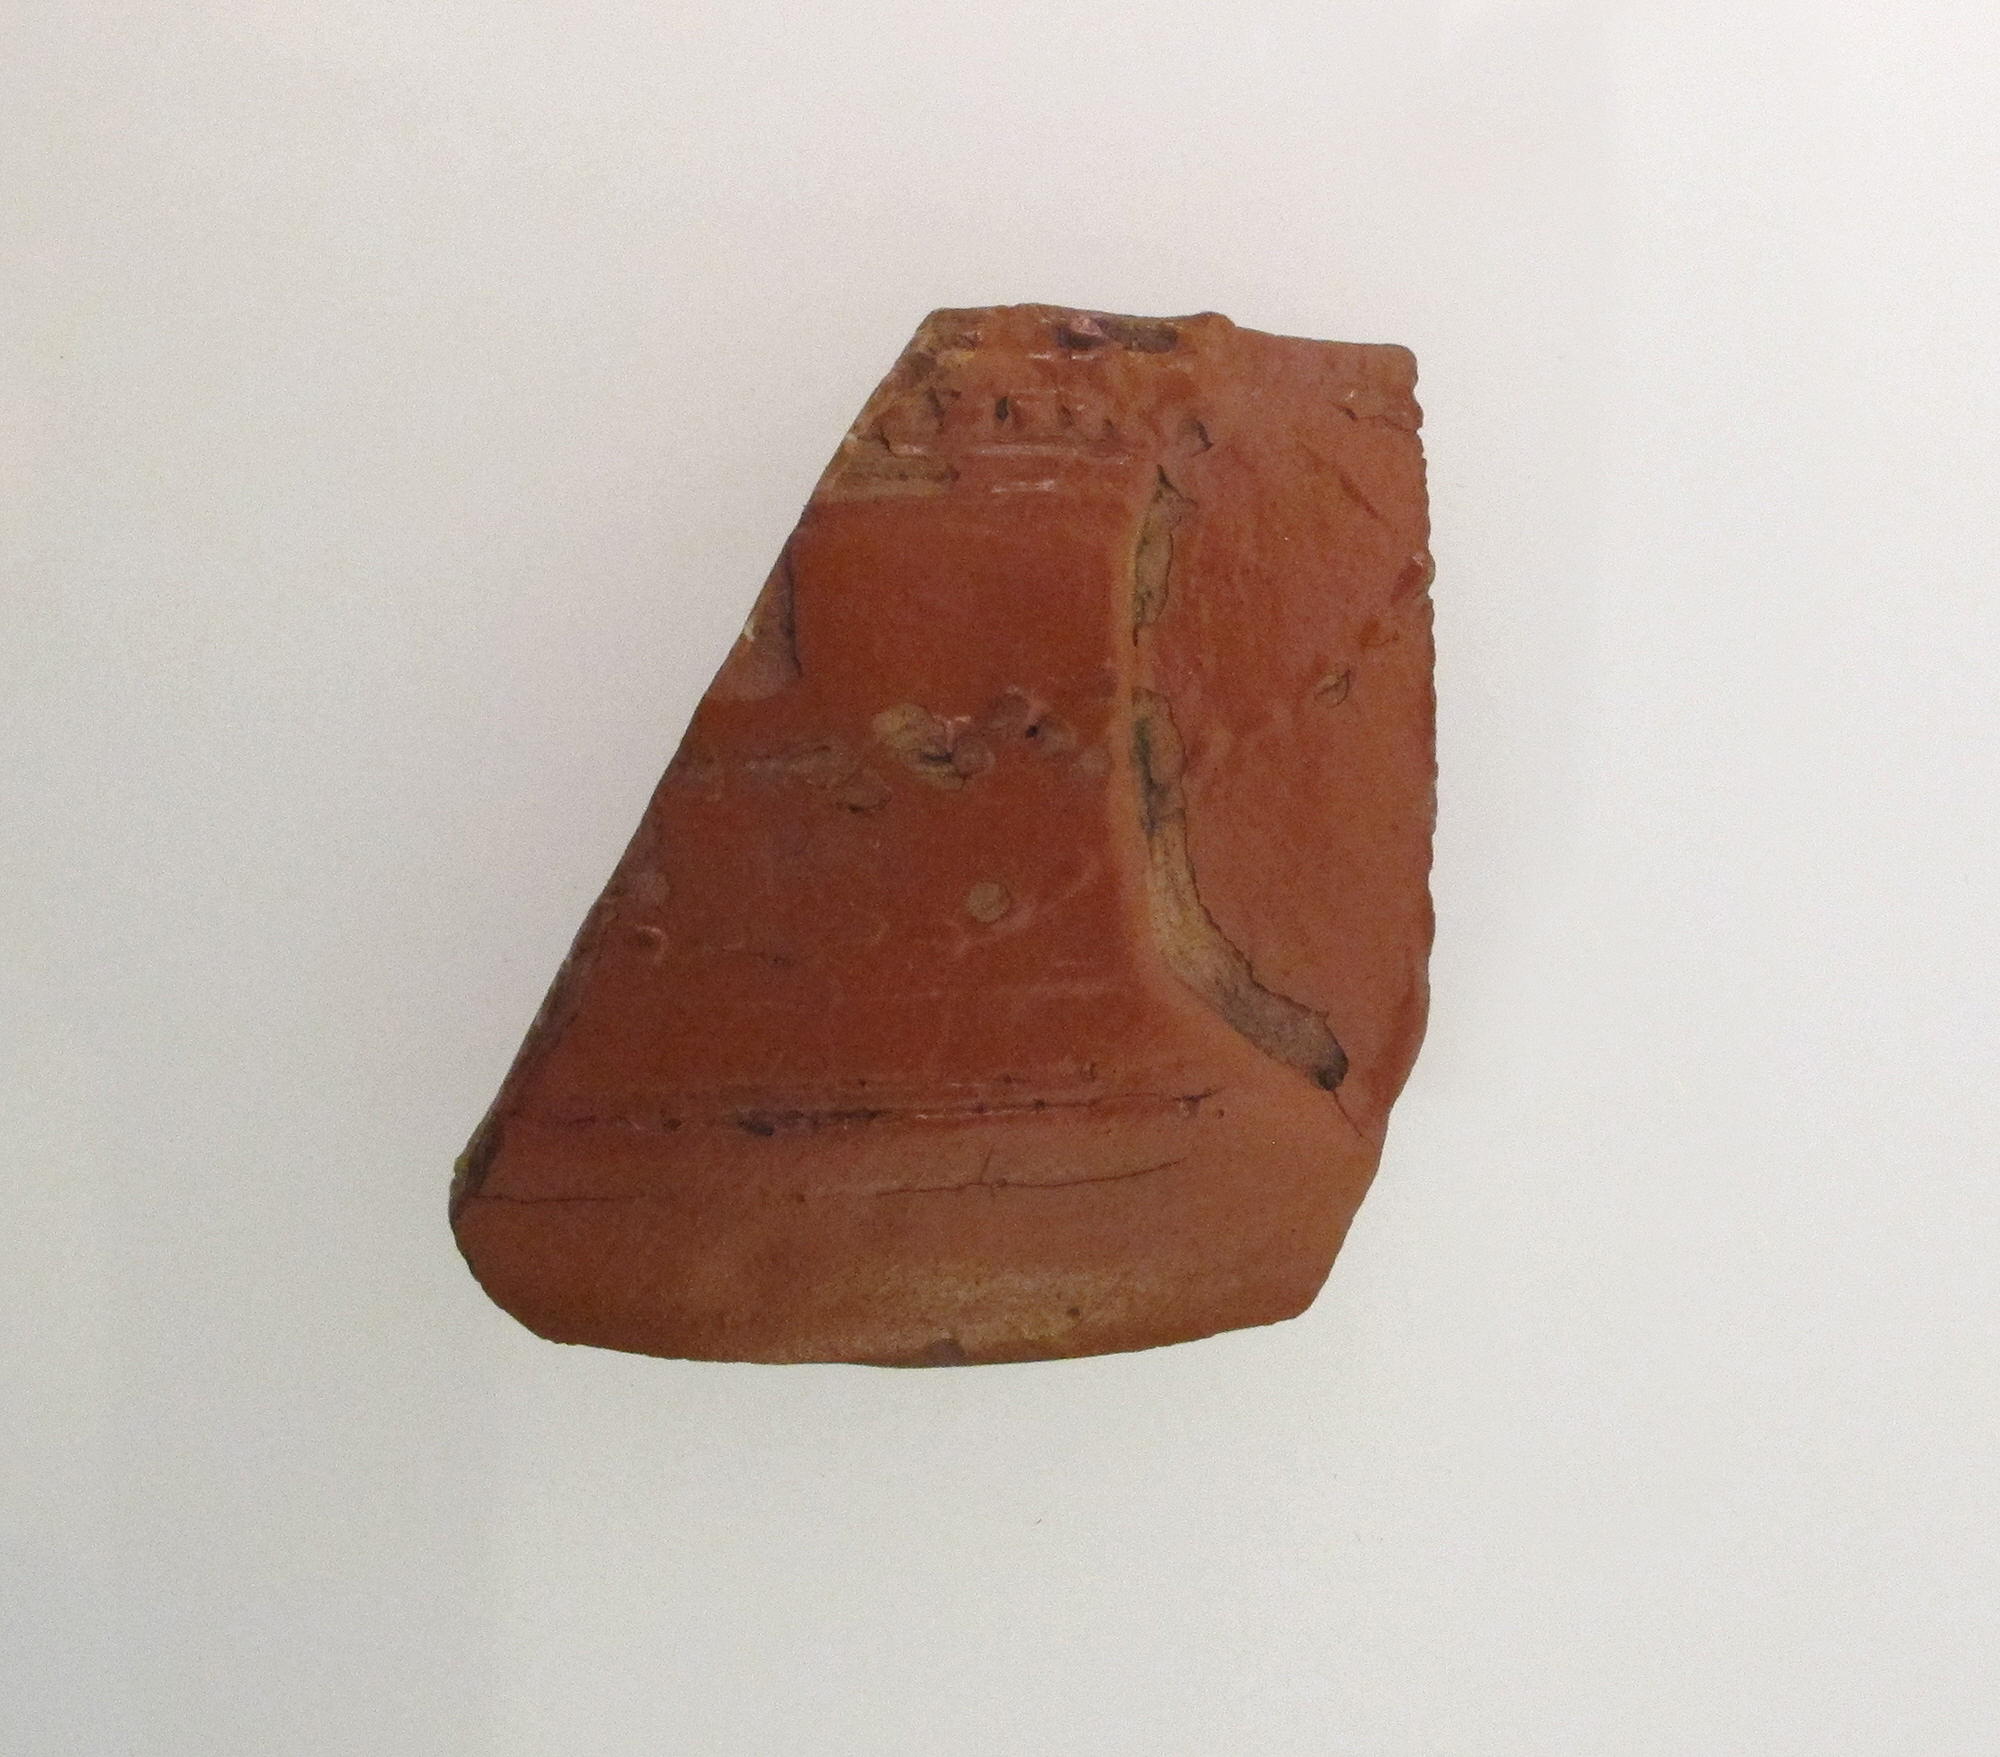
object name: vase fragment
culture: roman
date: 100 BCE-100 CE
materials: terracotta